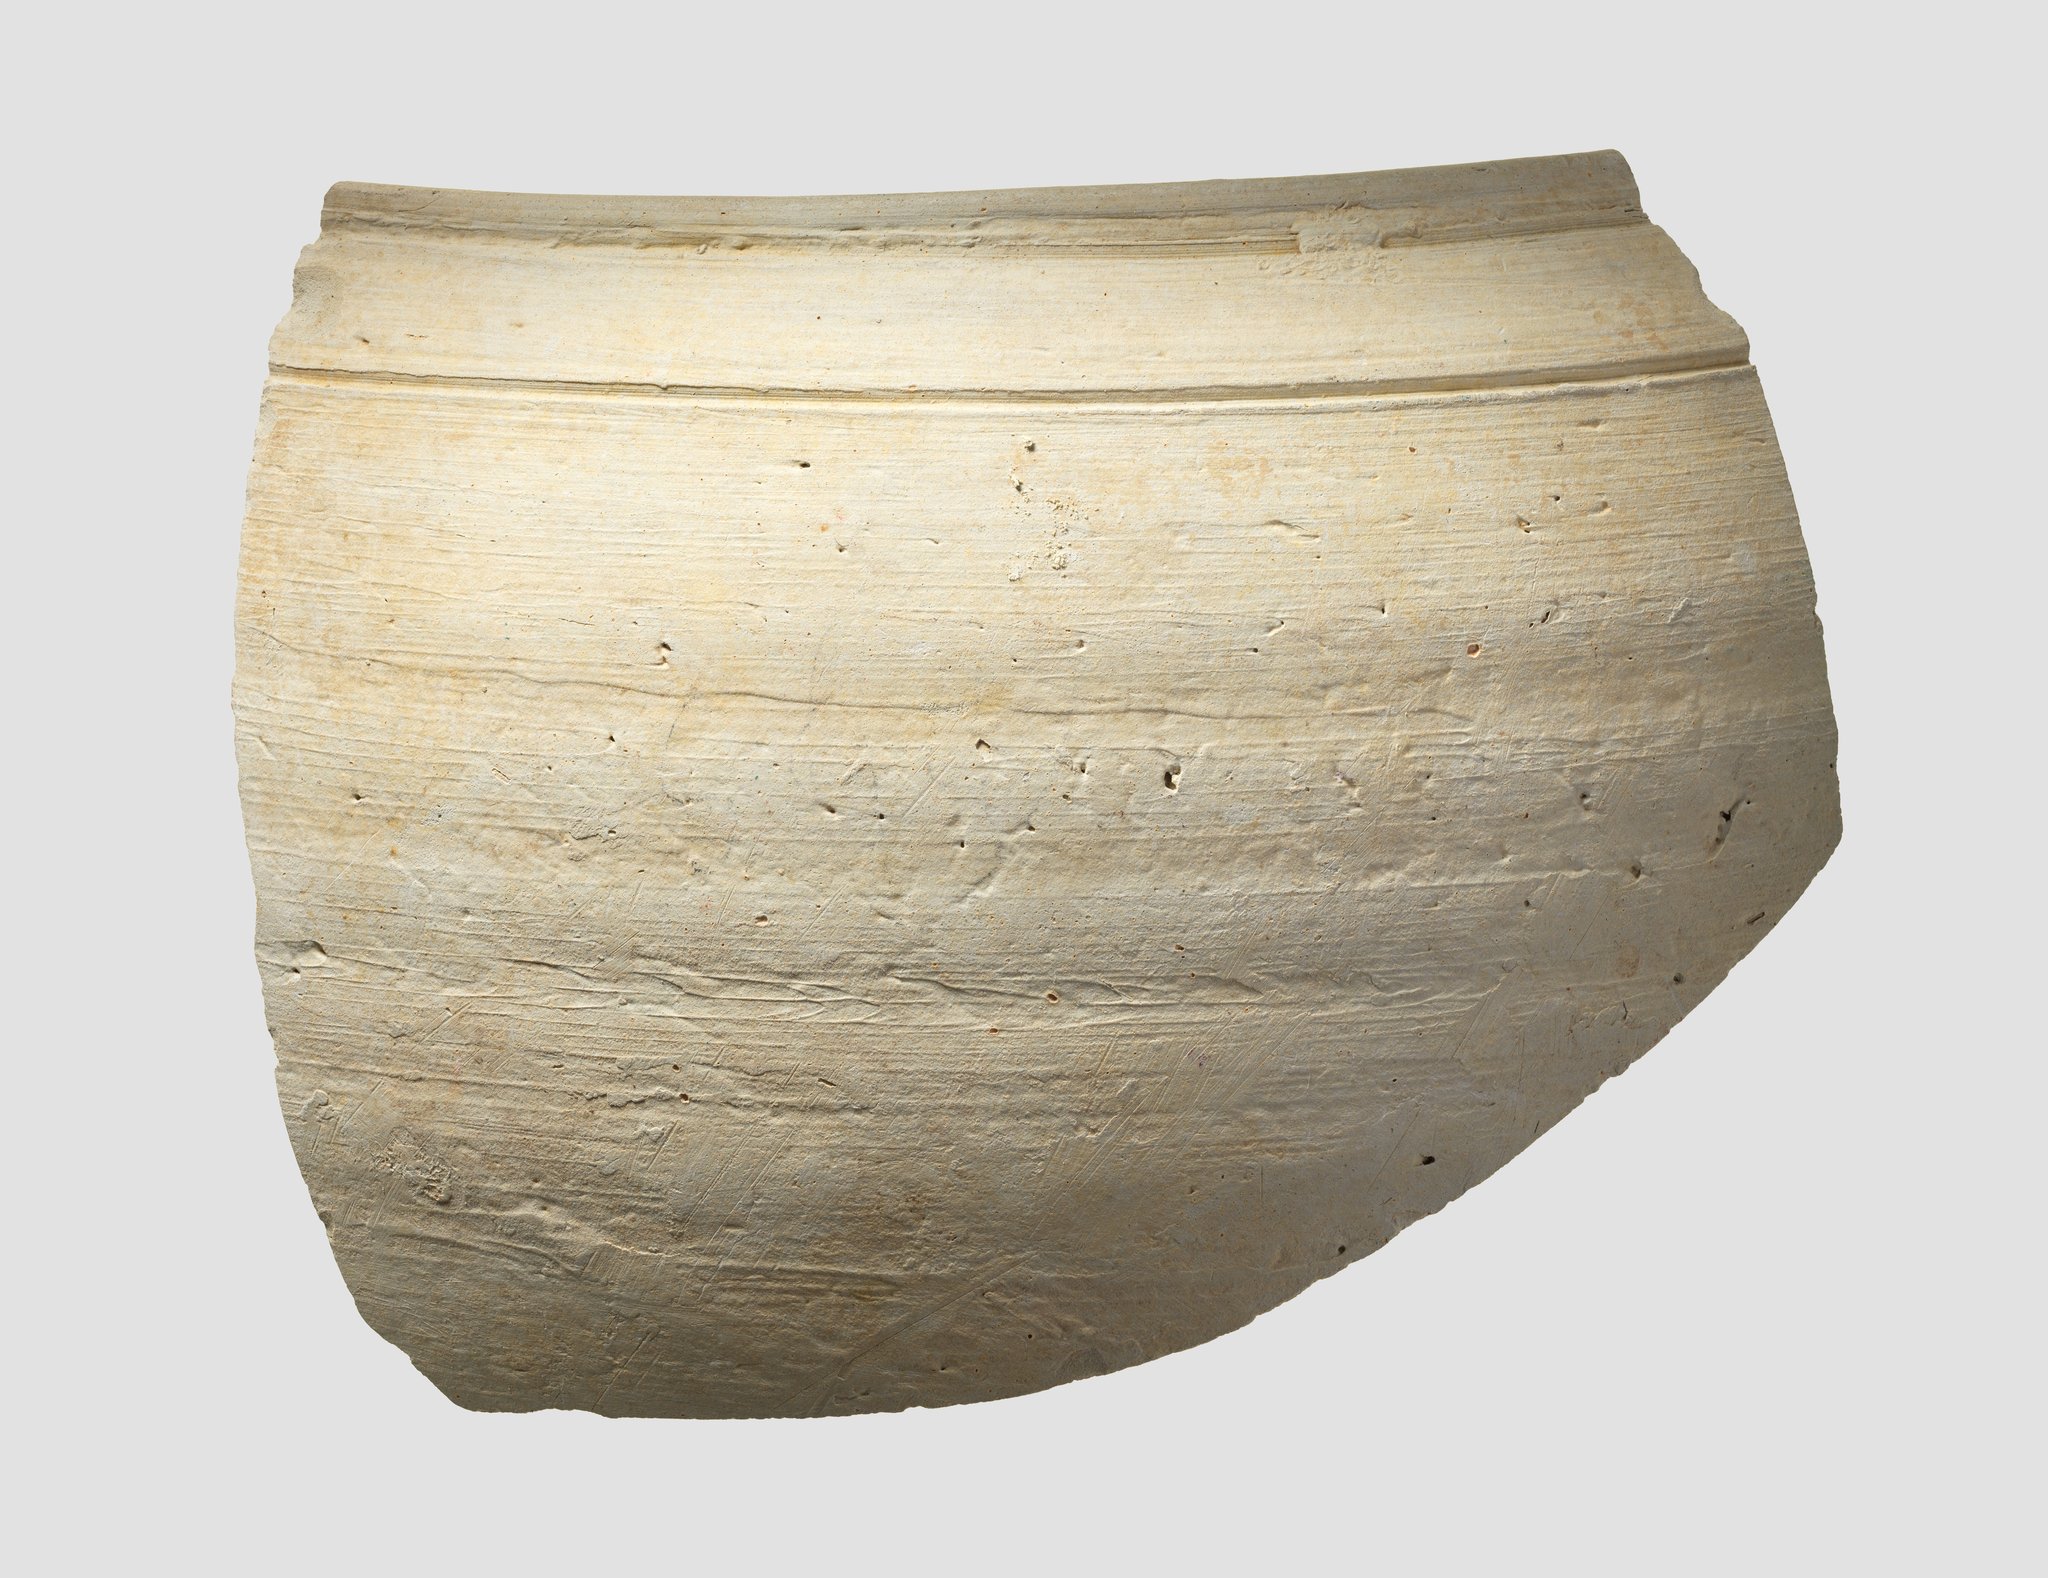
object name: bowl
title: Bowl sherd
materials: ceramic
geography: mesopotamia